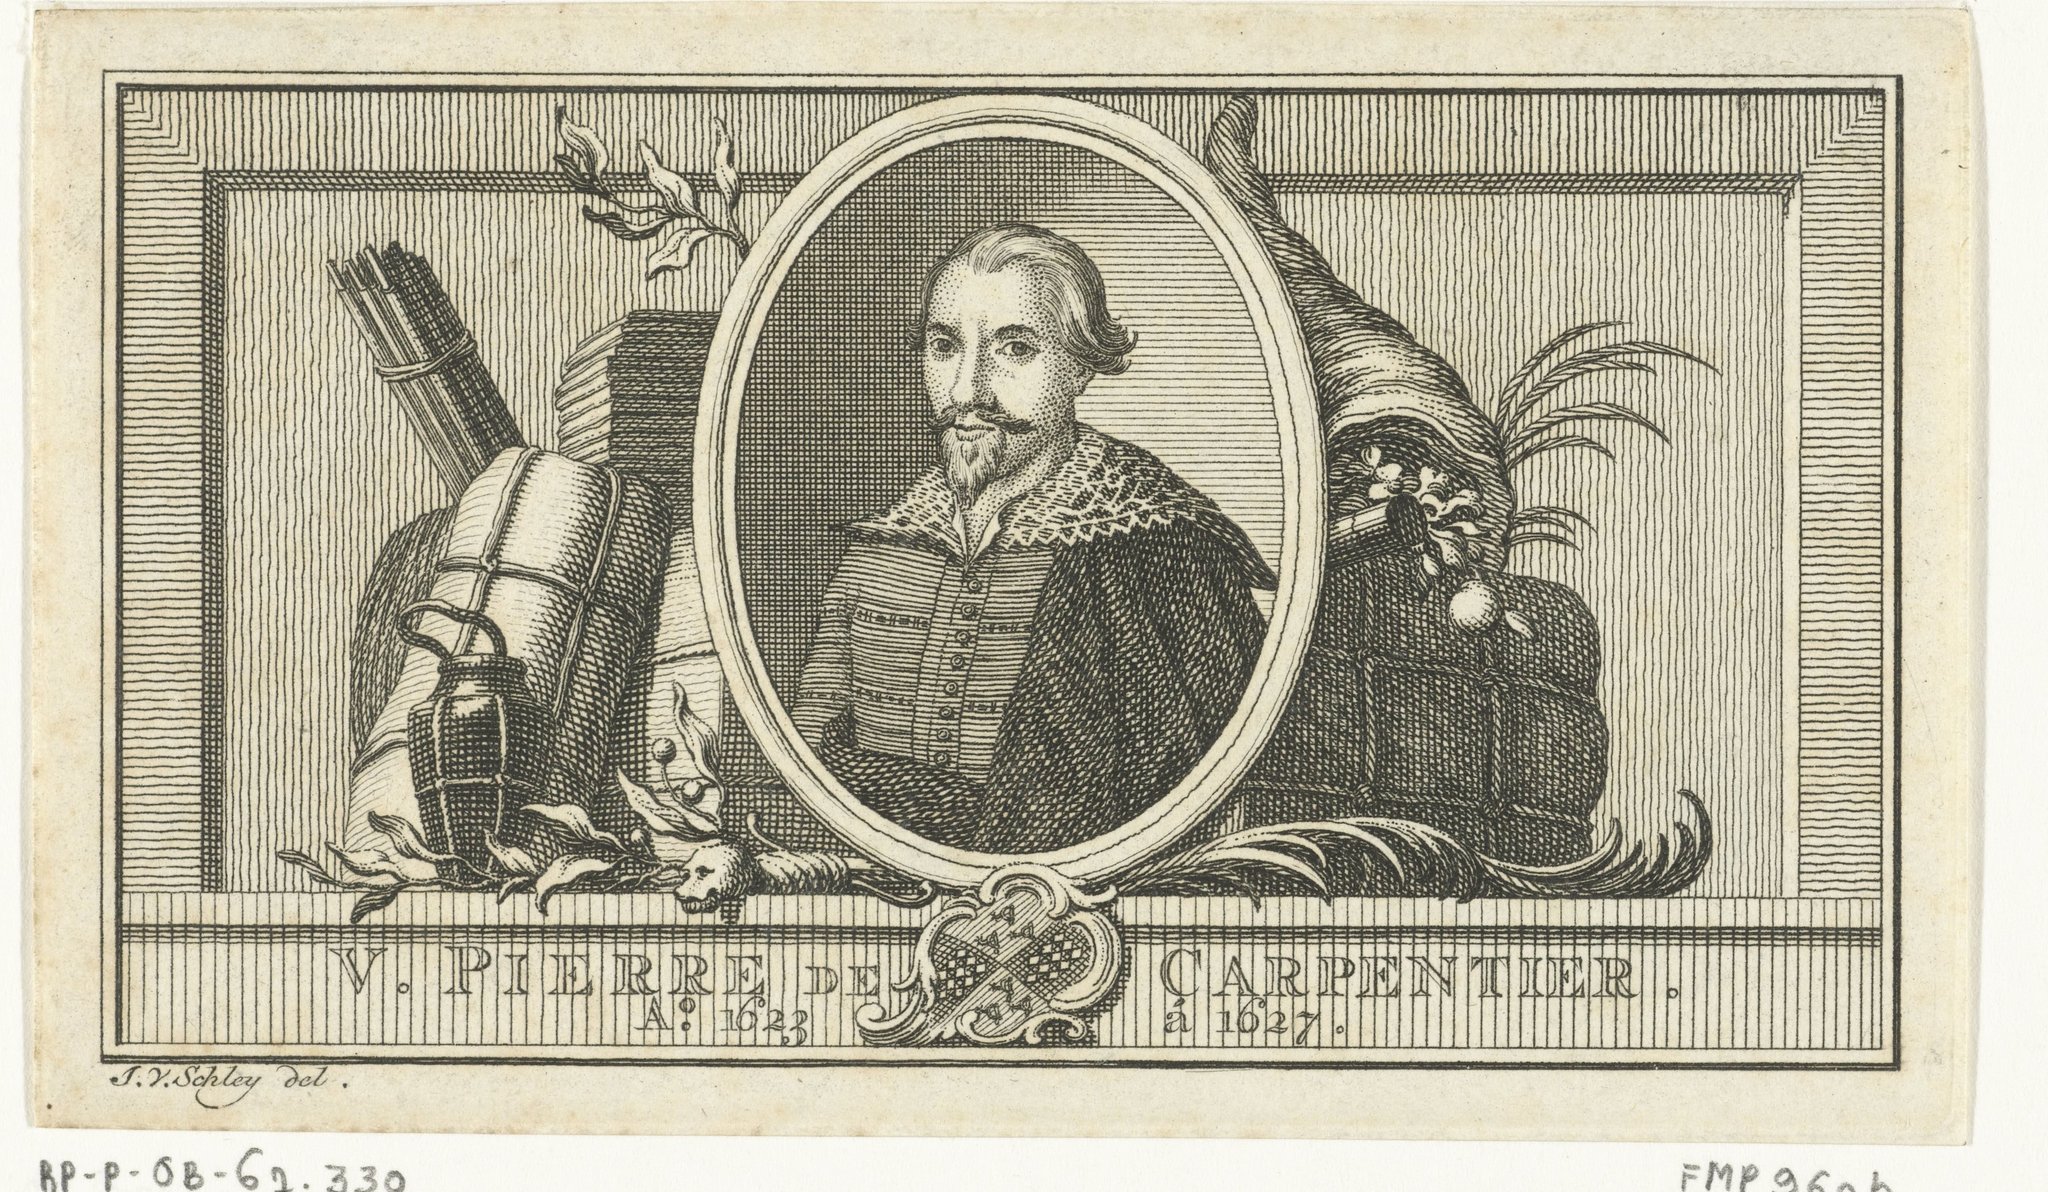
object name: print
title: Portret van Pieter de Carpentier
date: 1763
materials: paper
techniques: engraving, etching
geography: the hague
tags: antwerp, amsterdam, 'cornucopia', horn of plenty, trees: palm-tree (+ thorny twig), trees: olive-tree (+ sprig, twig)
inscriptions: collector's mark: Lugt 964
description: Proefdruk voor illustratie in: Du Bois, J.P.I. Vies des gouverneurs généraux avec l'abrégé de l'histoire des établissemens hollandais aux Indes Orientales. Den Haag: Pierre de Hondt, 1763, p. 72.